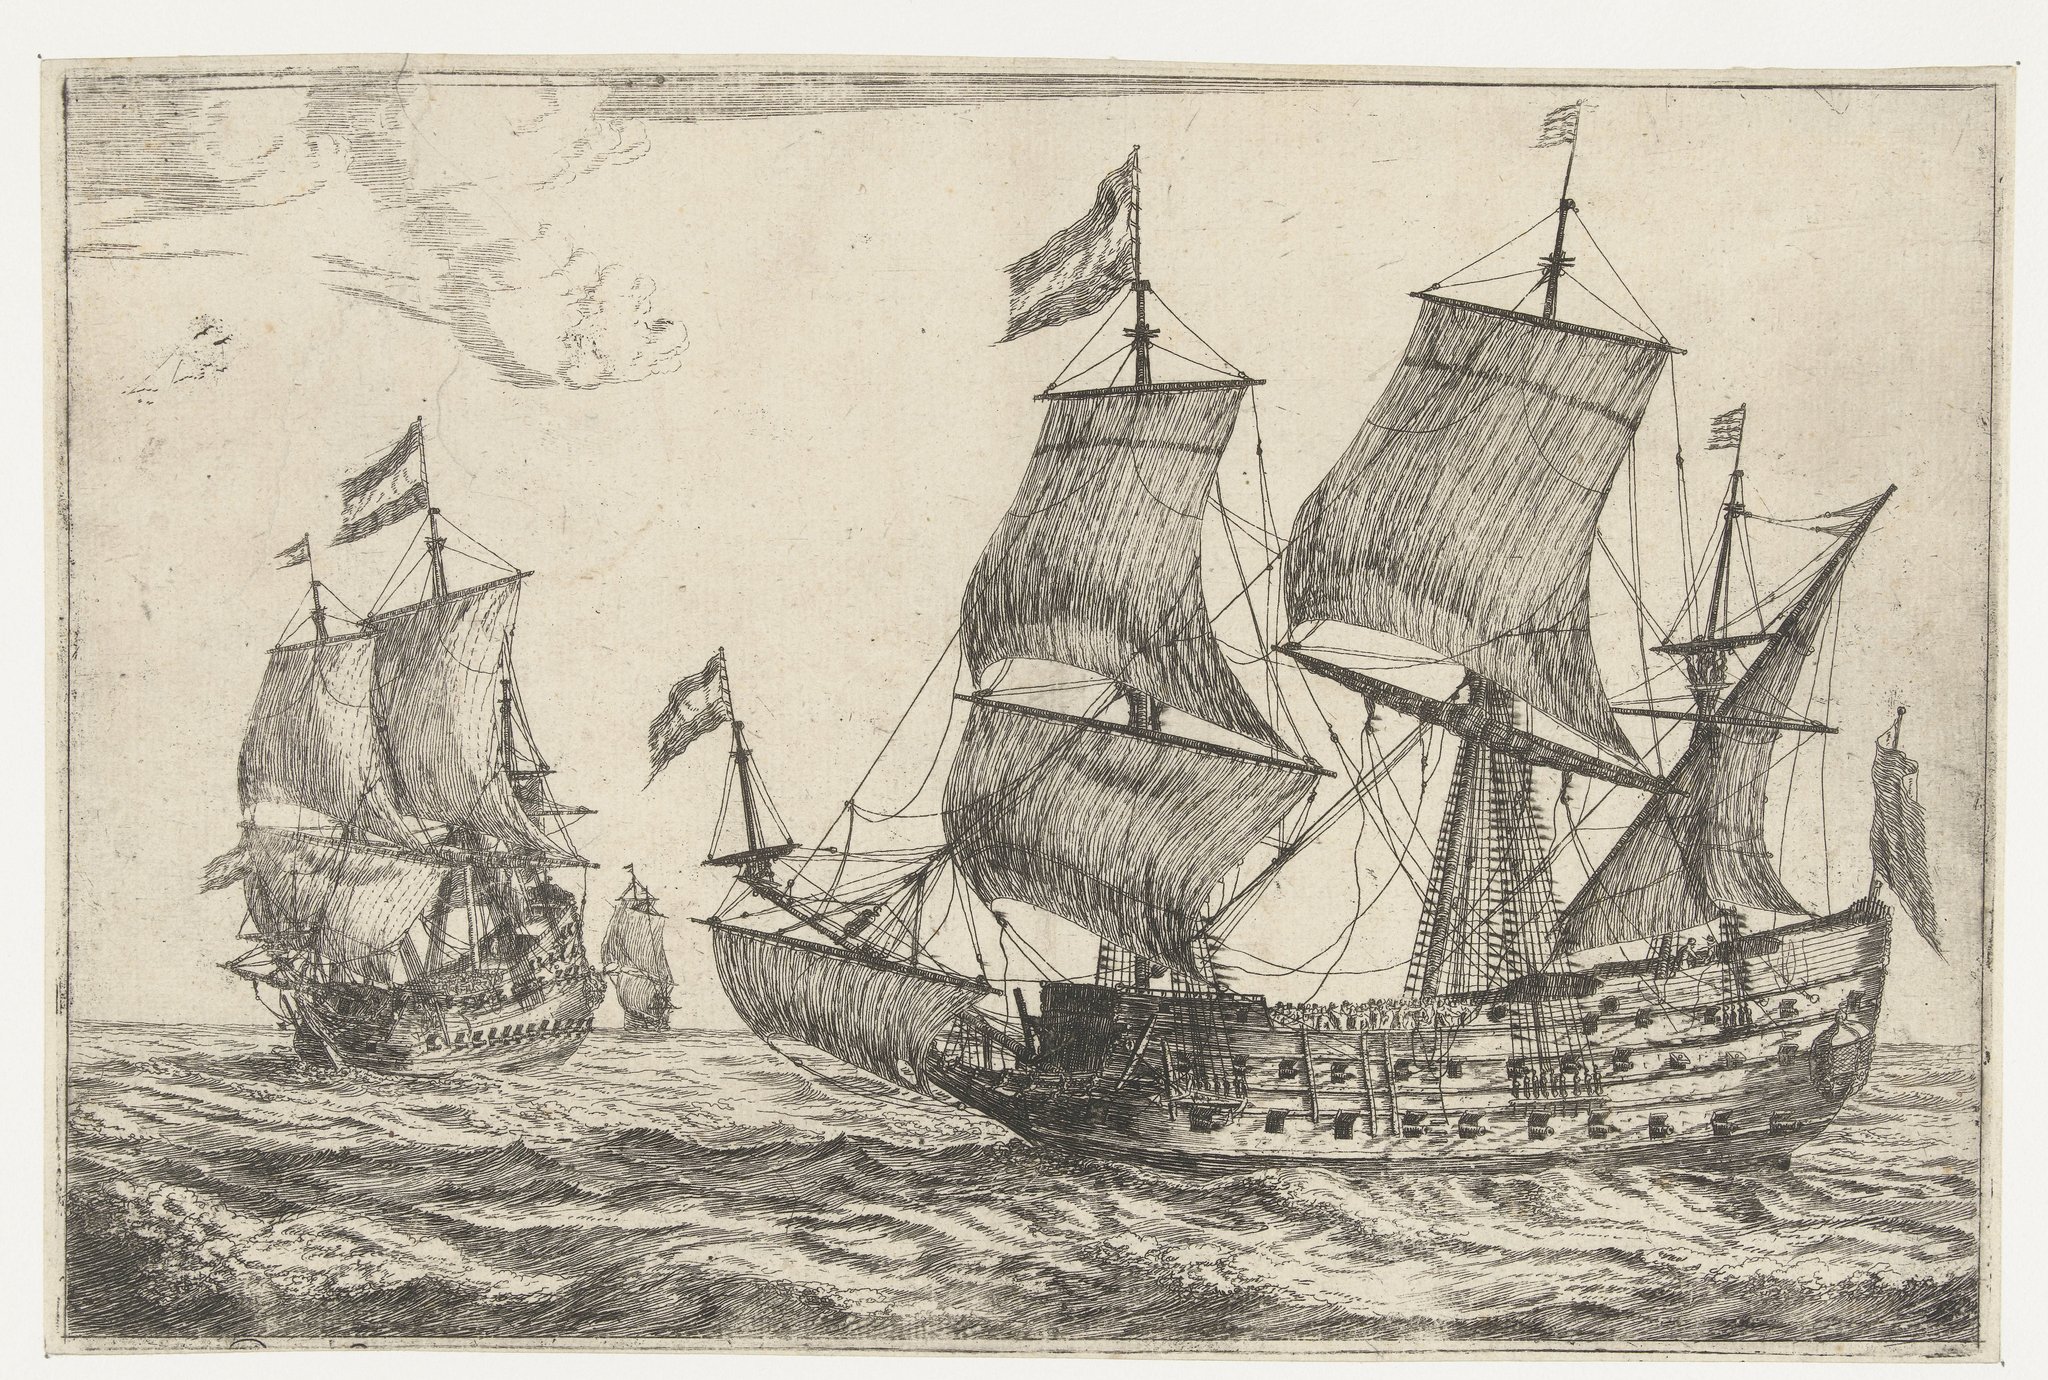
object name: print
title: Twee grote oorlogsschepen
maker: reinier nooms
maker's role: draughtsman, painter, print maker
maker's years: 1623-1664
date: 1650-1664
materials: paper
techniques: etching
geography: netherlands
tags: sailing-ship, sailing-boat (with name)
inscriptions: collector's mark: Lugt 2228a, collector's mark: Lugt 345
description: Twee grote Nederlandse oorlogsschepen met bemanning op zee, aan de horizon een derde schip.